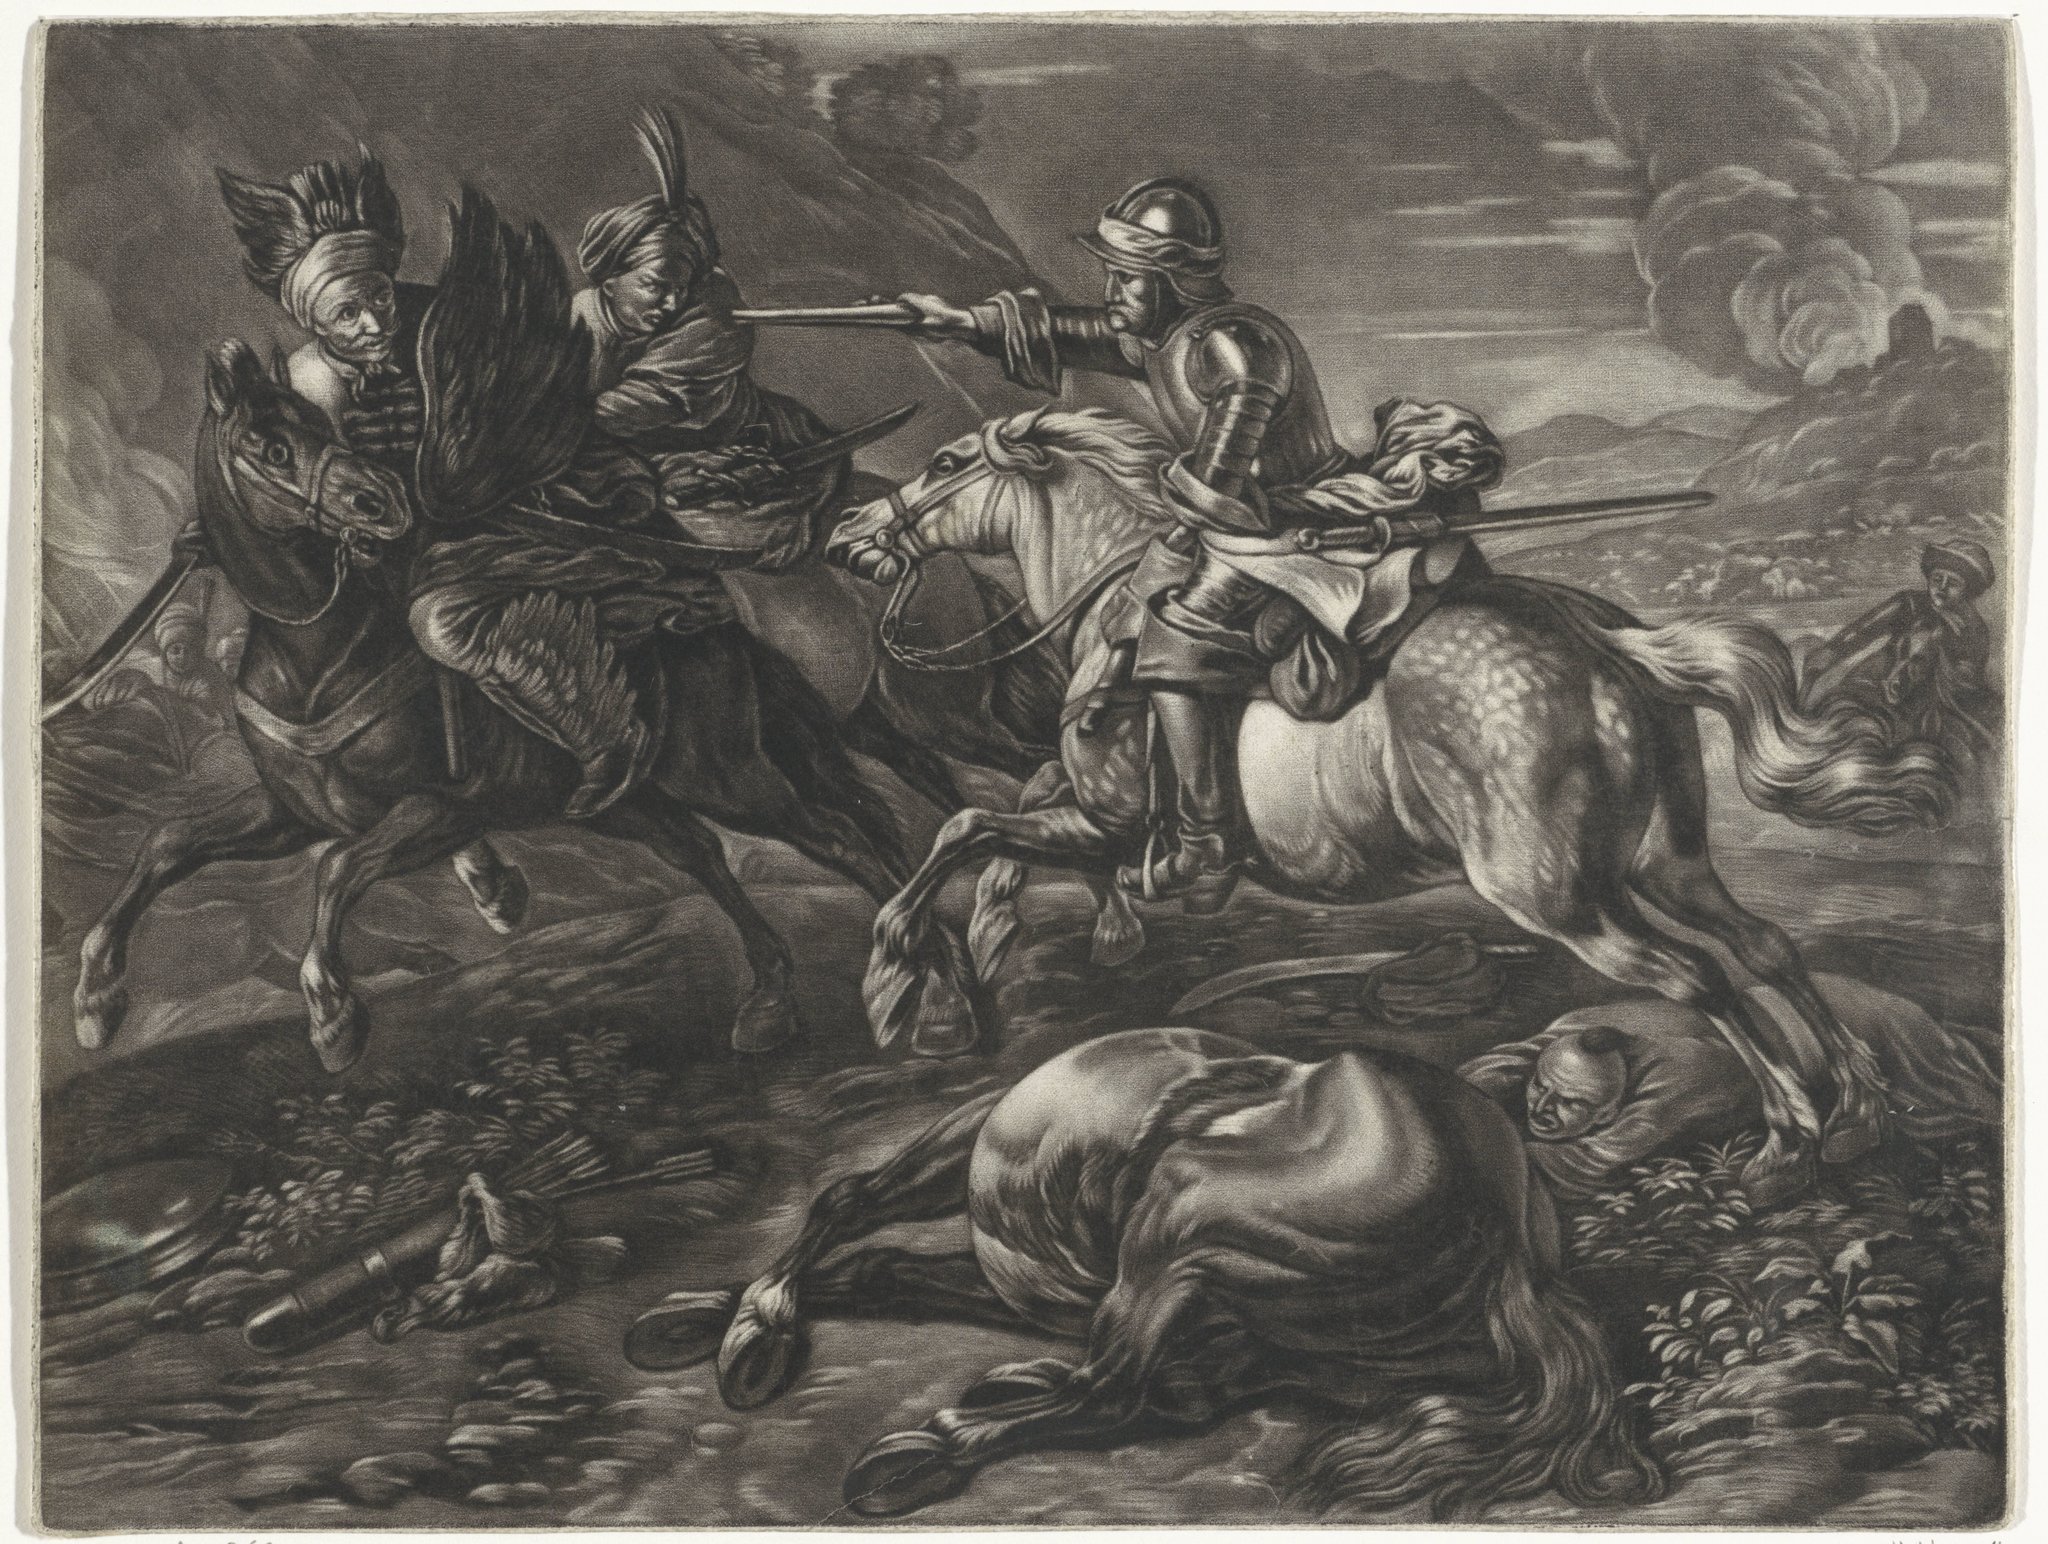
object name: print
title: Janitsaren in gevecht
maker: jacob gole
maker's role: print maker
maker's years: 1660-1724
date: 1670-1724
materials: paper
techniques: mezzotint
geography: amsterdam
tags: asiatic races and peoples: turks, battle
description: De Janitsaren zijn verwikkeld in een ruitergevecht met een andere partij. Janitsaren waren de elitetroepen van het Ottomaanse hof.